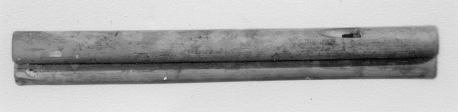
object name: tutatsu bioshi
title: Tutatsu-Bioshi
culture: japanese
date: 1801-1900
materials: bamboo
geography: japan